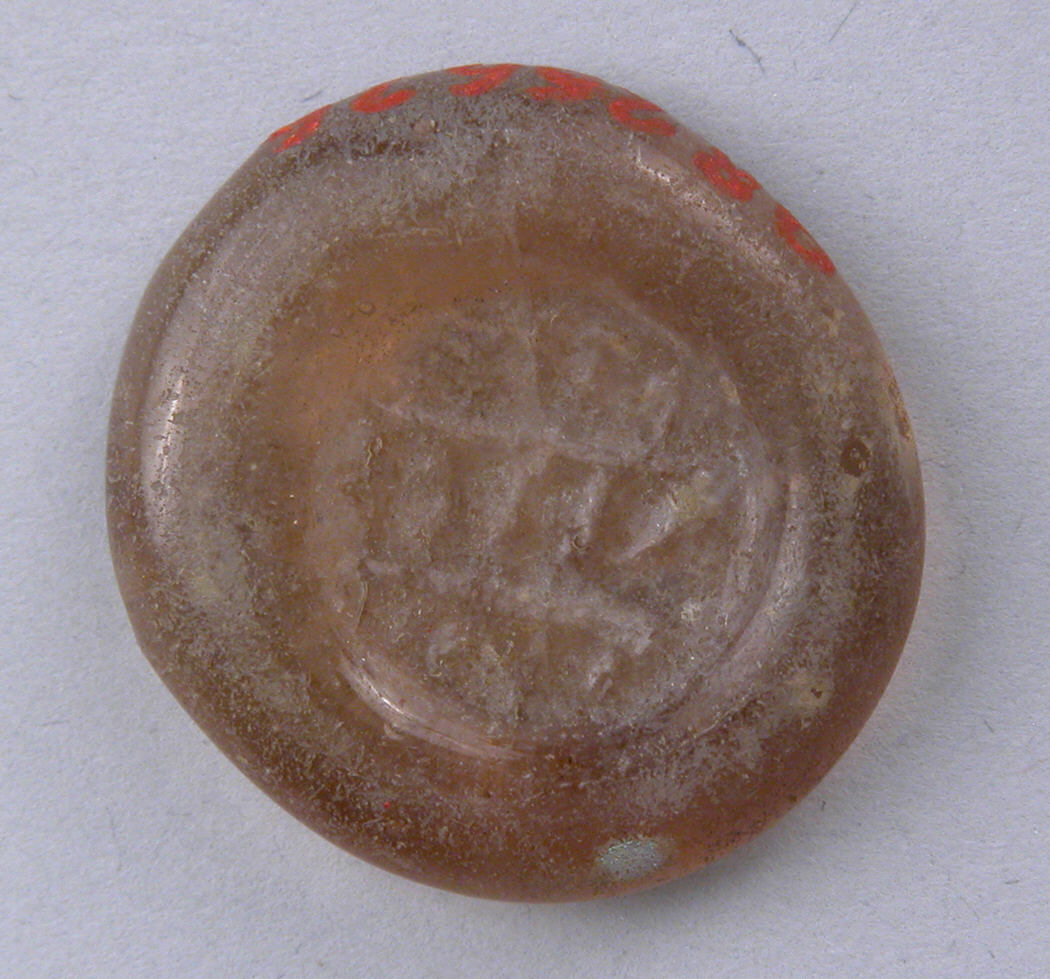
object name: coin weight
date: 801-1000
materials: glass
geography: egypt